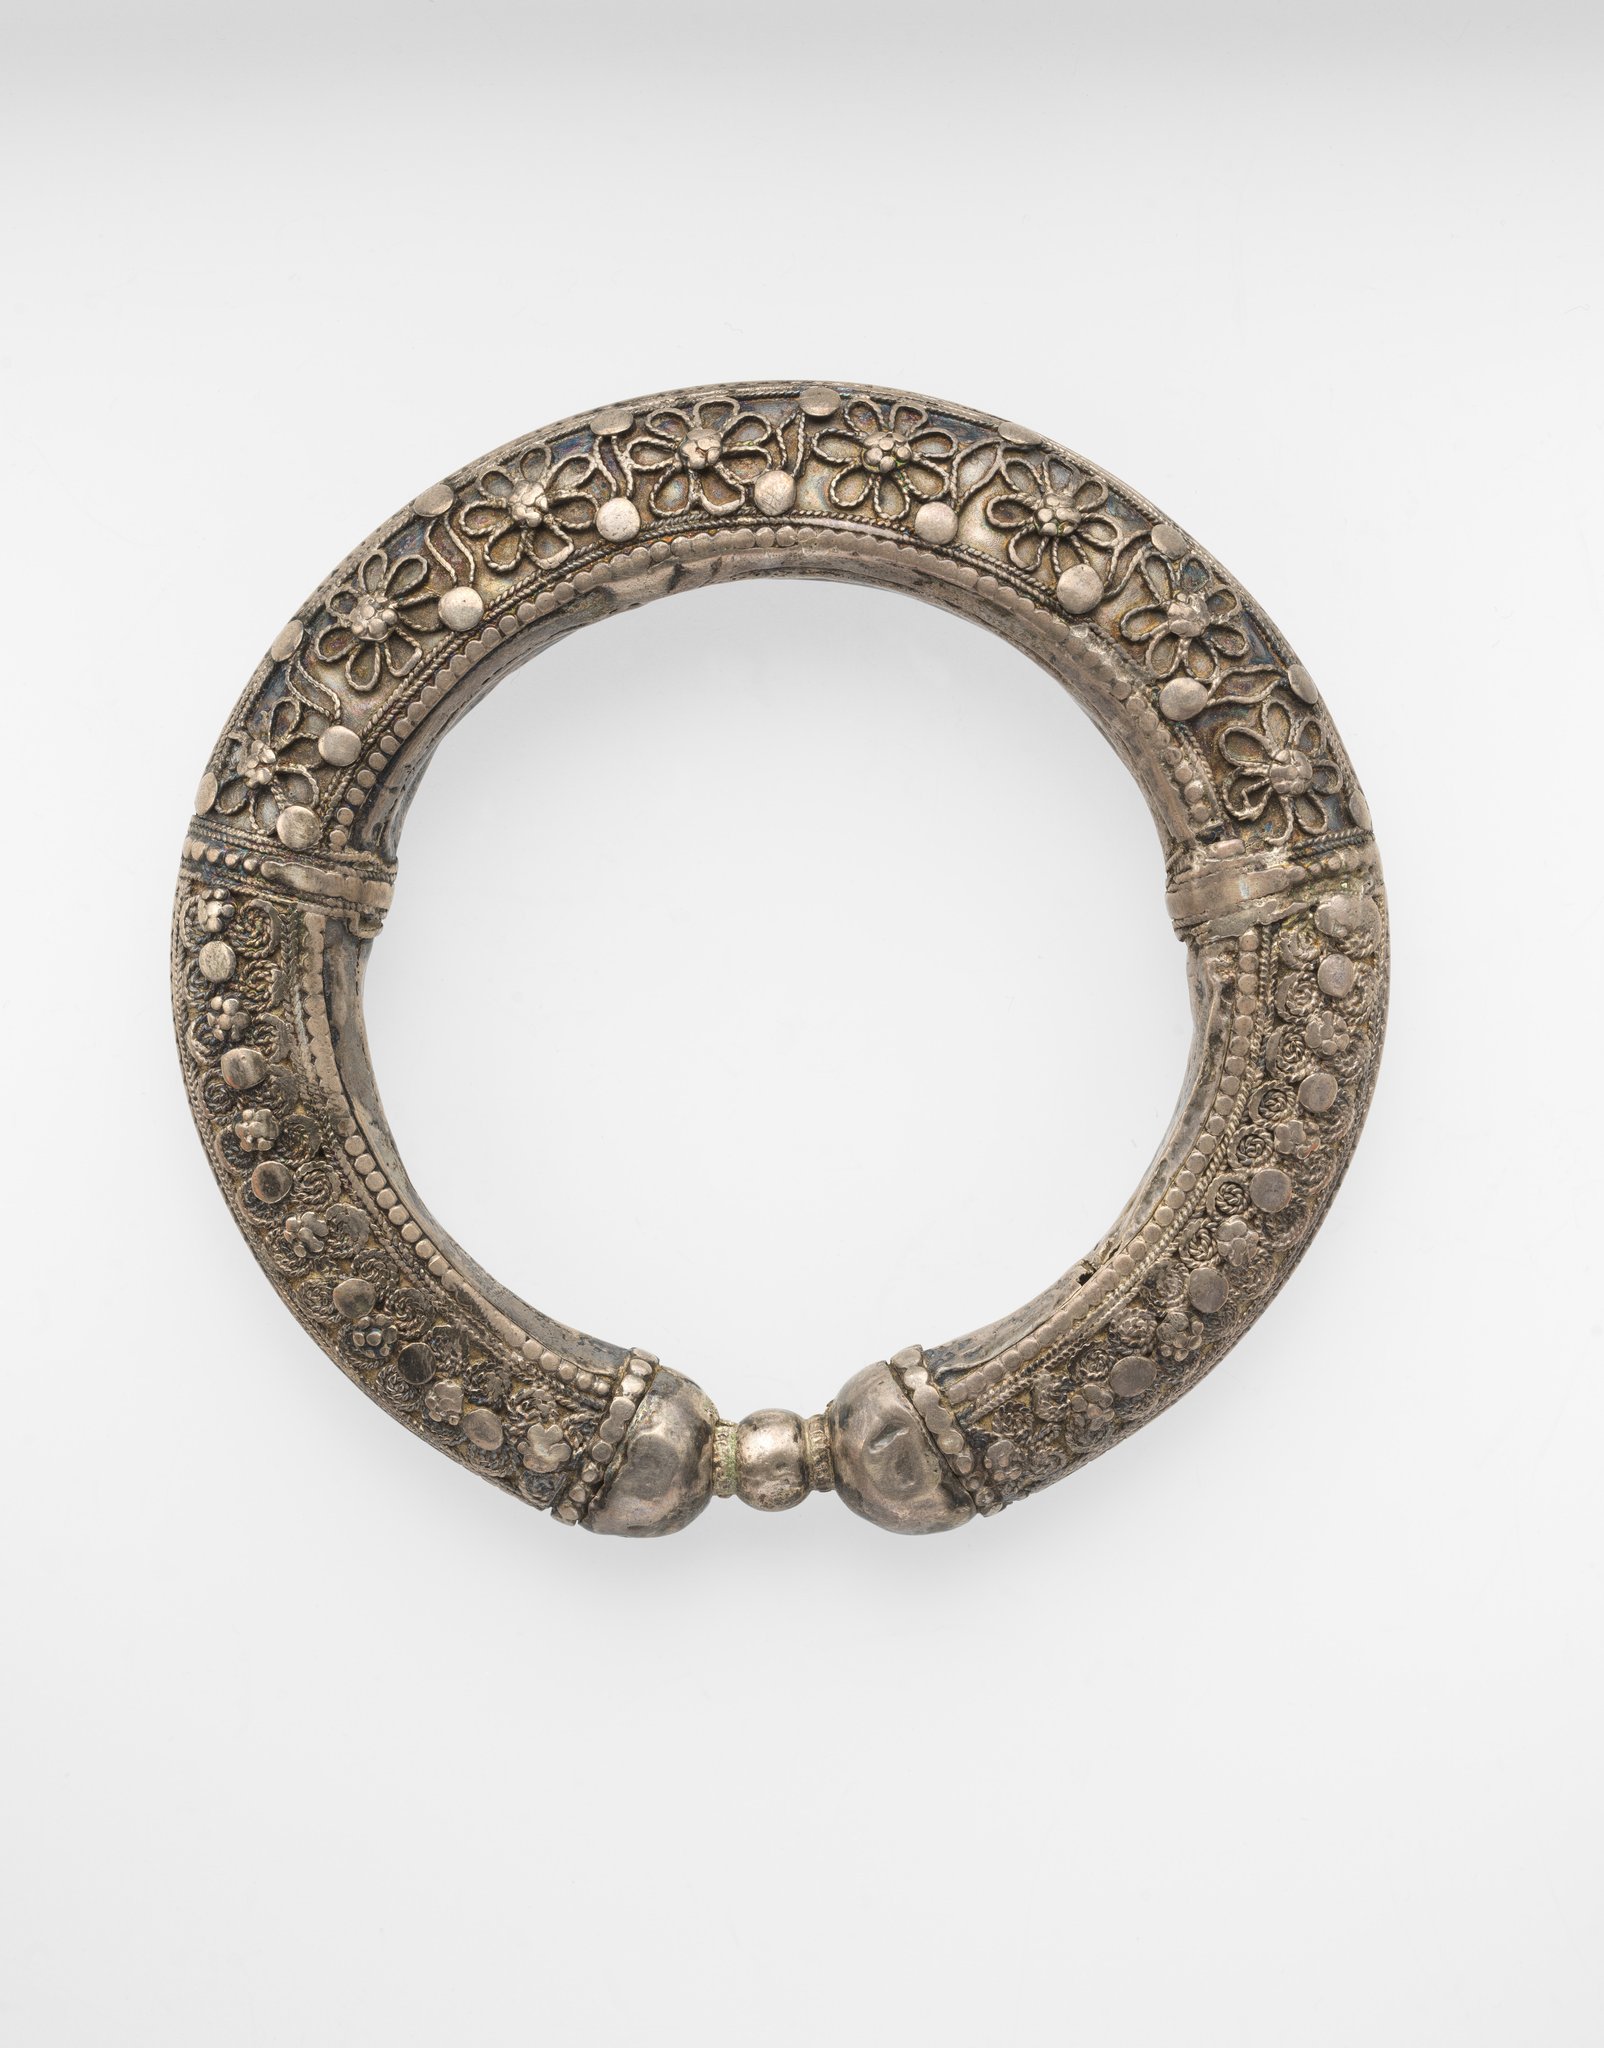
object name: anklet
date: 1801-1900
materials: silver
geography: india